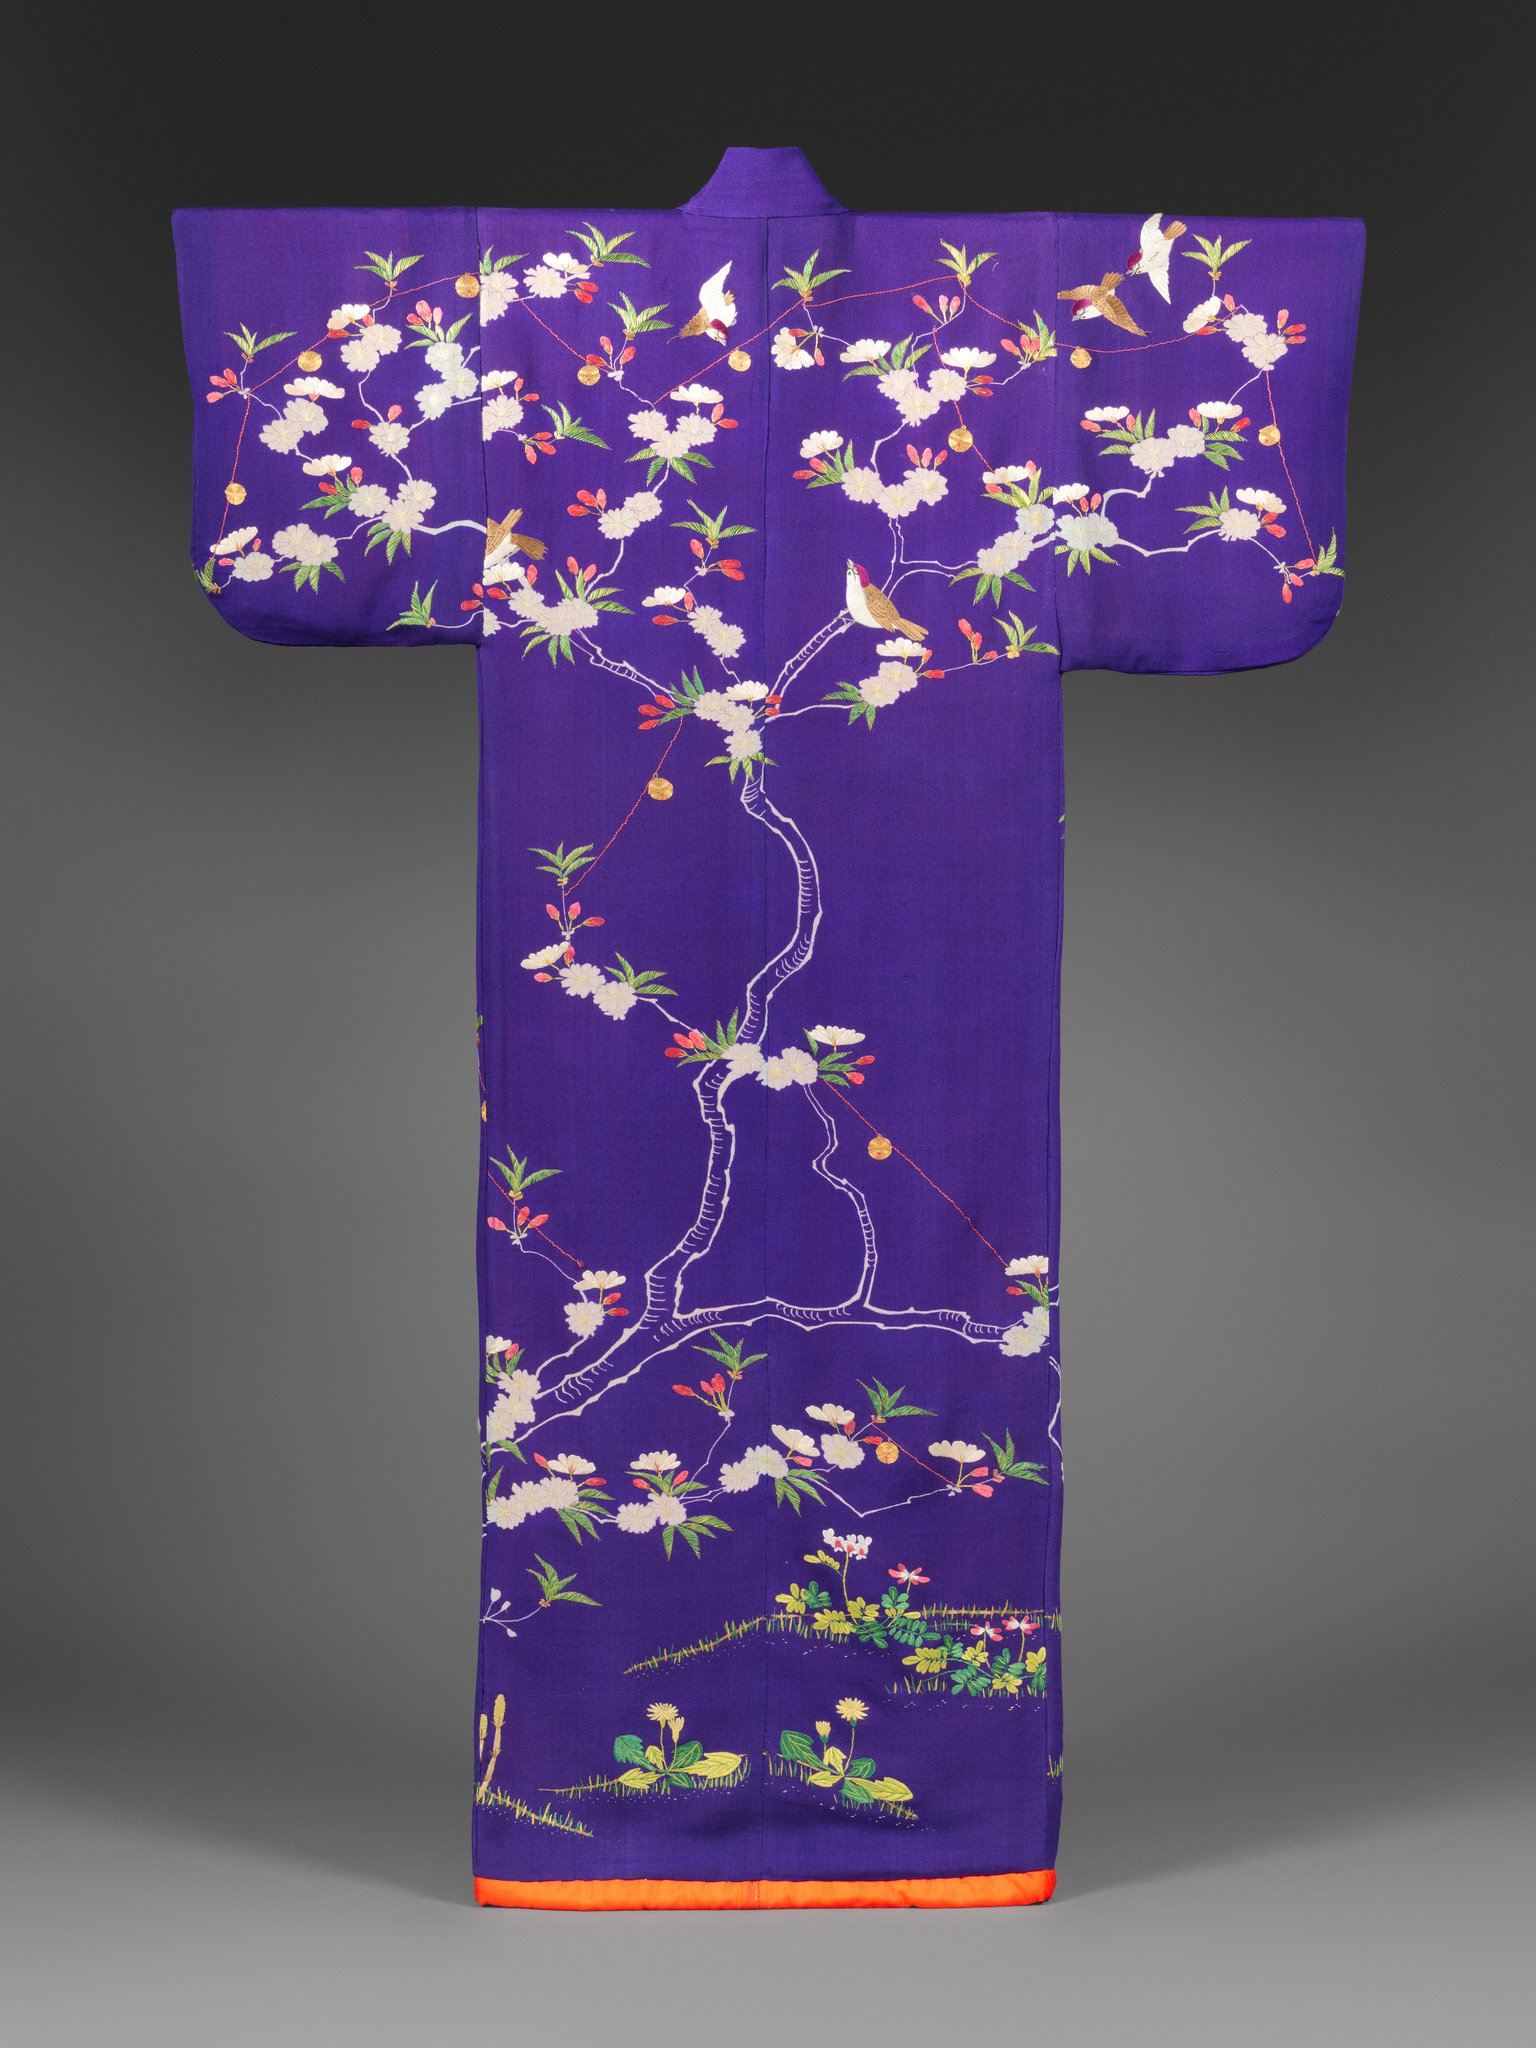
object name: kosode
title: Court Lady’s Garment (Kosode) with Swallows and Bells on Blossoming Cherry Tree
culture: japanese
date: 1834-1866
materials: gold thread, silk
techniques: embroidery